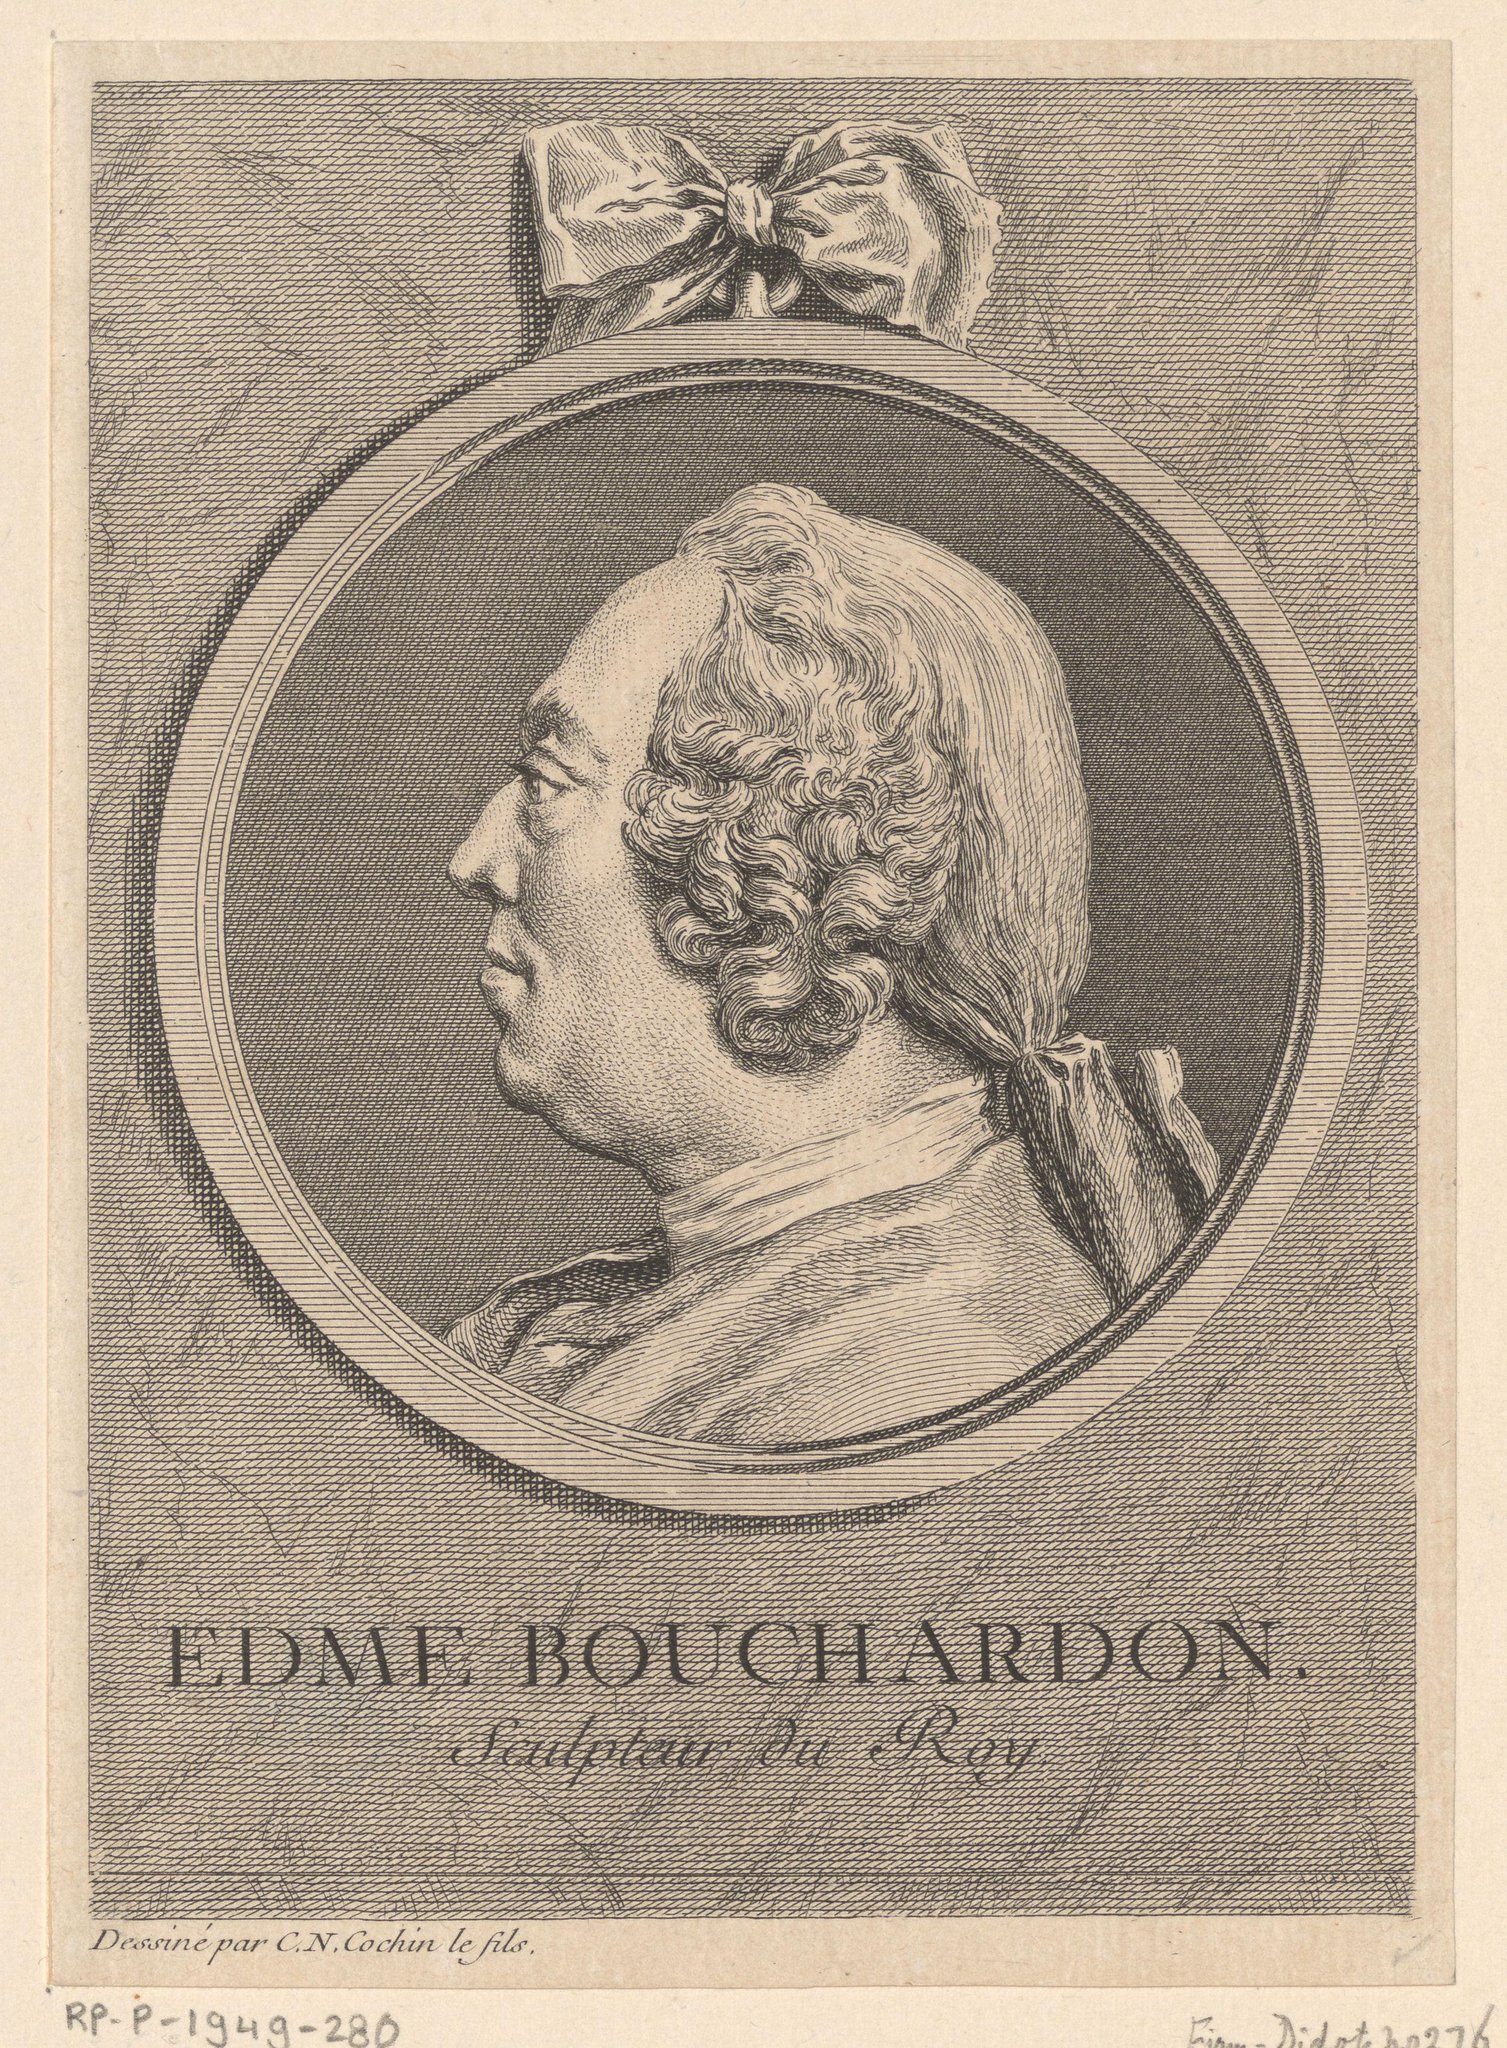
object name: print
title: Portret van Edmé Bouchardon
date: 1732-1775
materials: paper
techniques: engraving, etching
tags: print maker, draughtsman, sculptor, edme bouchardon, historical persons, portrait, self-portrait of artist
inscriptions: collector's mark: Lugt 2228, collector's mark: Lugt 4347